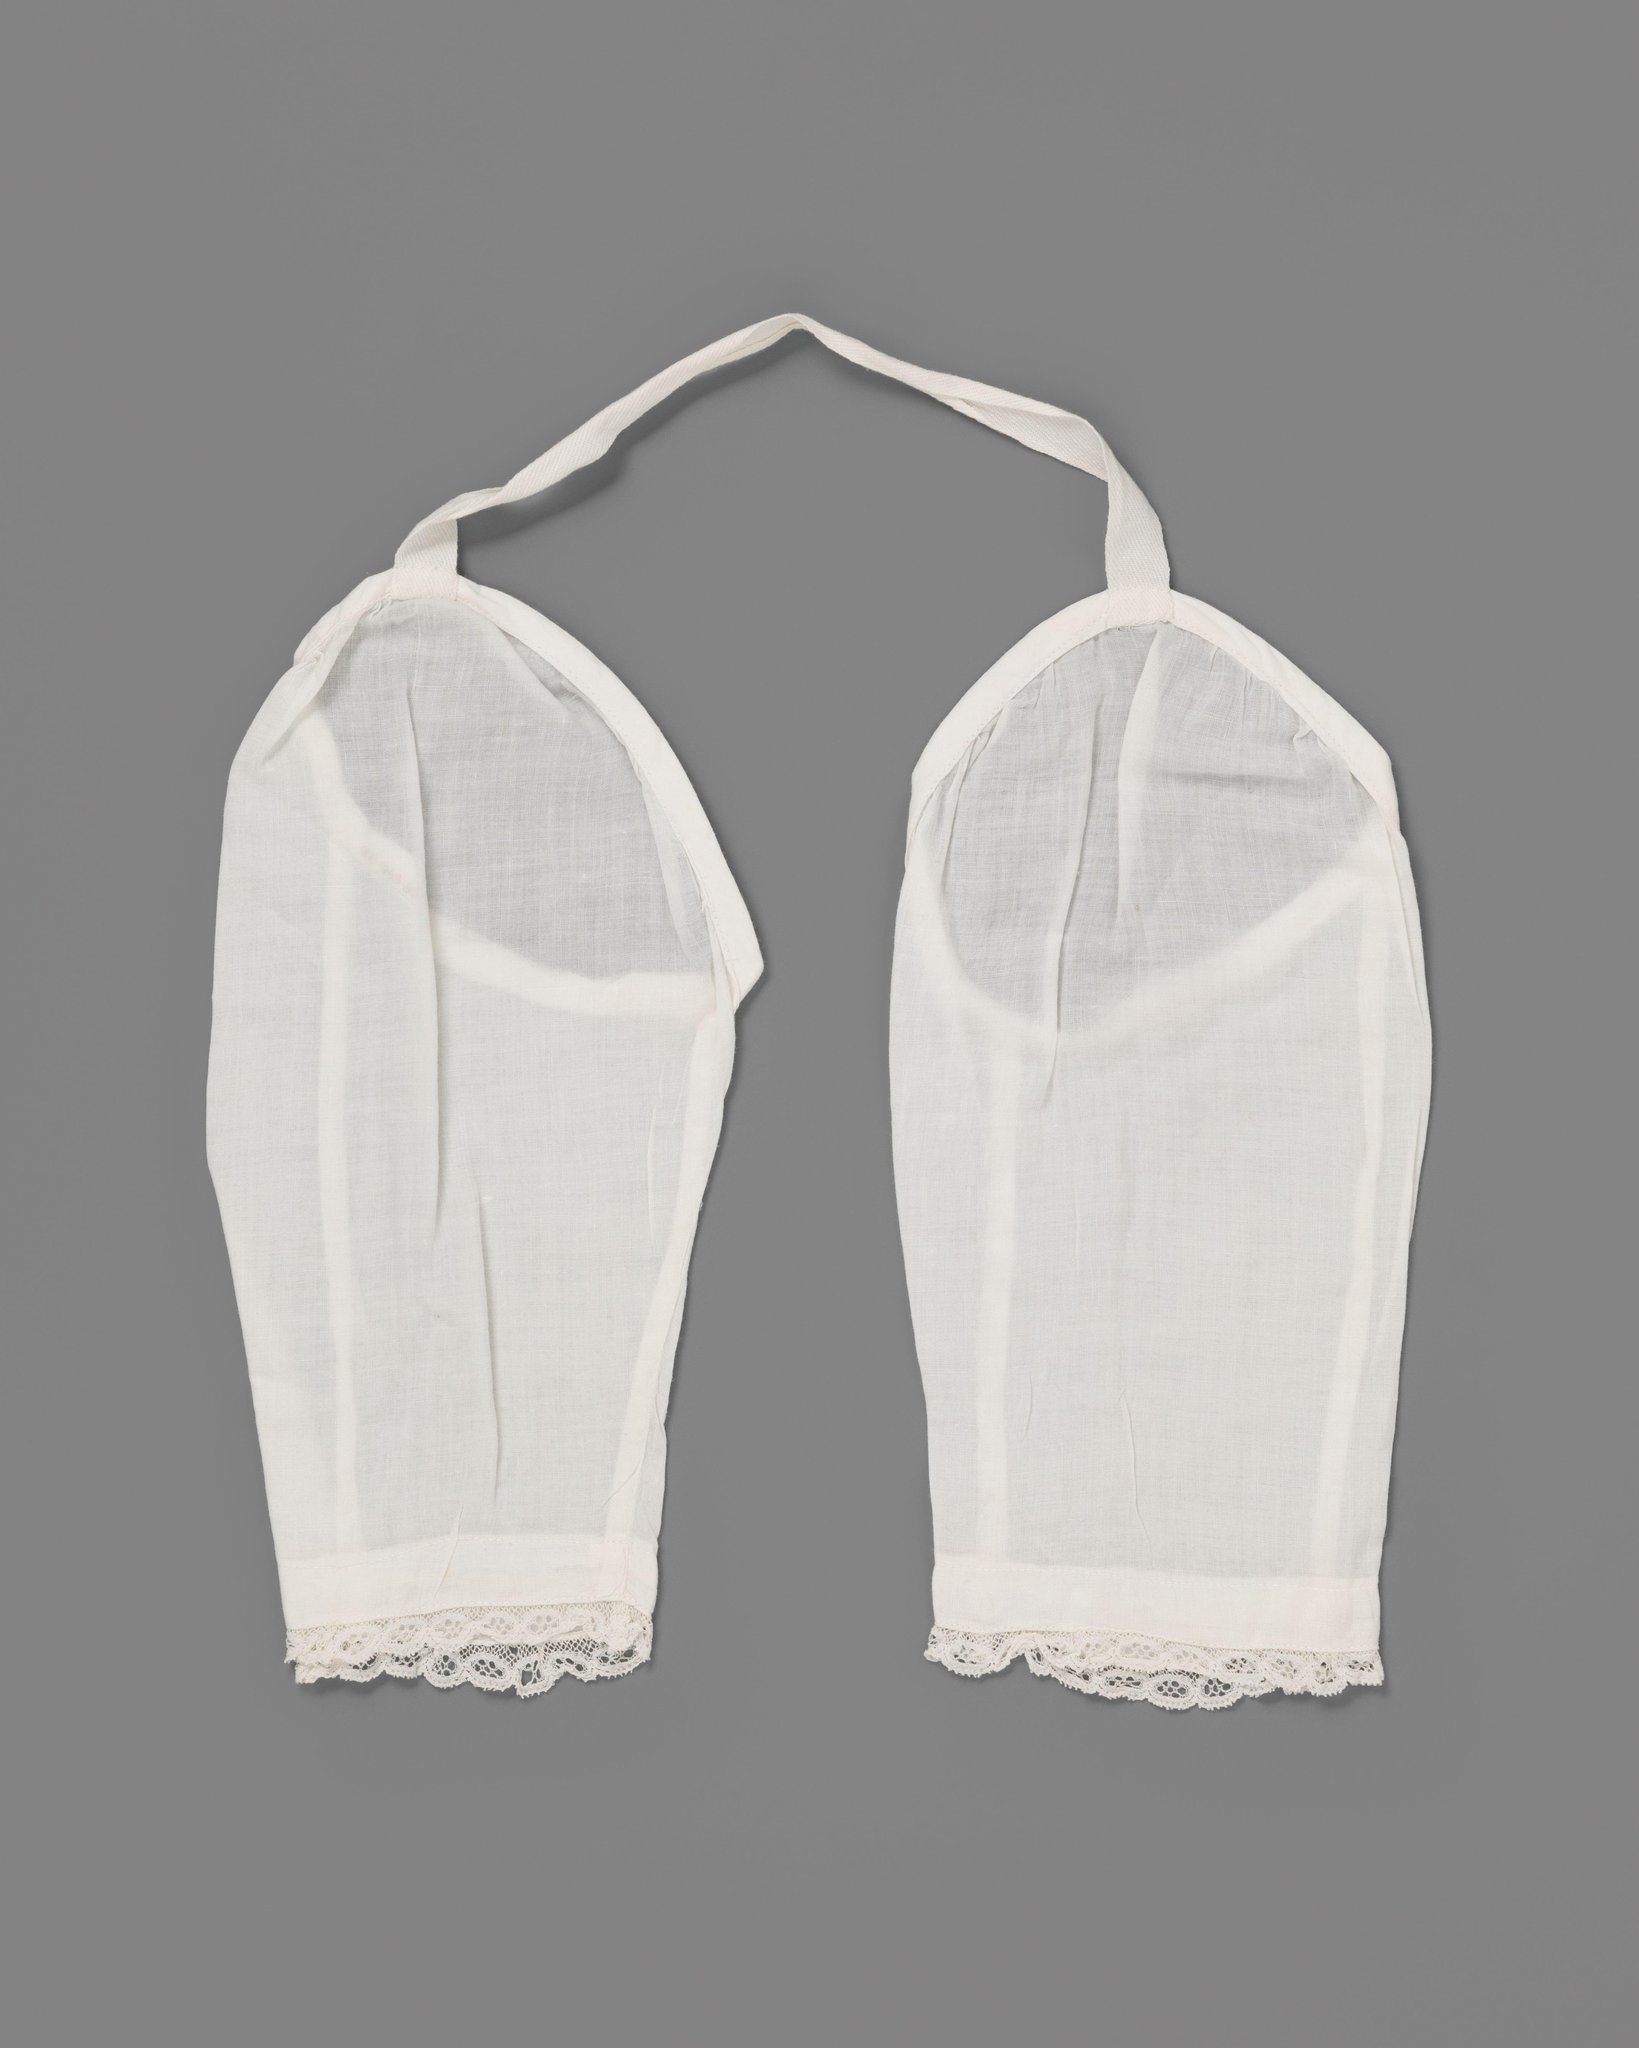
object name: womenswear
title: Ondermouw van linnen met rand van kloskant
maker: Anonymous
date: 1875-1900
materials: linen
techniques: lace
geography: western europe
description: Ondermouw van linnen met rand van kloskant. Zit met band vast aan mouw inv.nr. BK-1965-67-C-1.